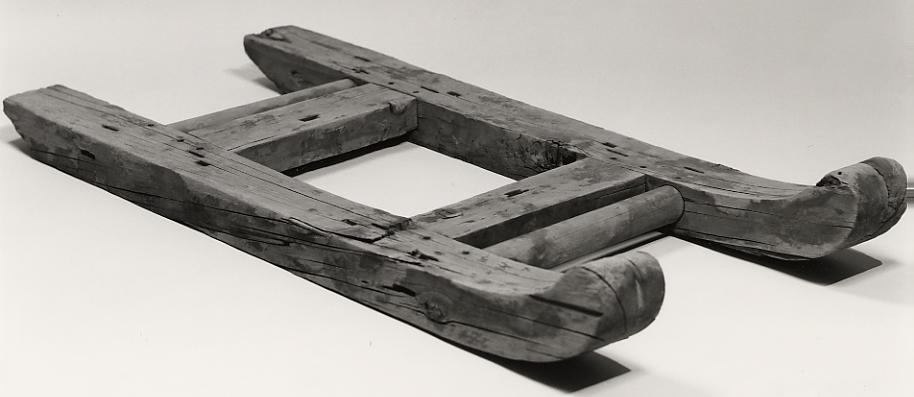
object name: sledge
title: Sledge from mortuary complex of Senwosret I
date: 1961-1917 BCE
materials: wood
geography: egypt